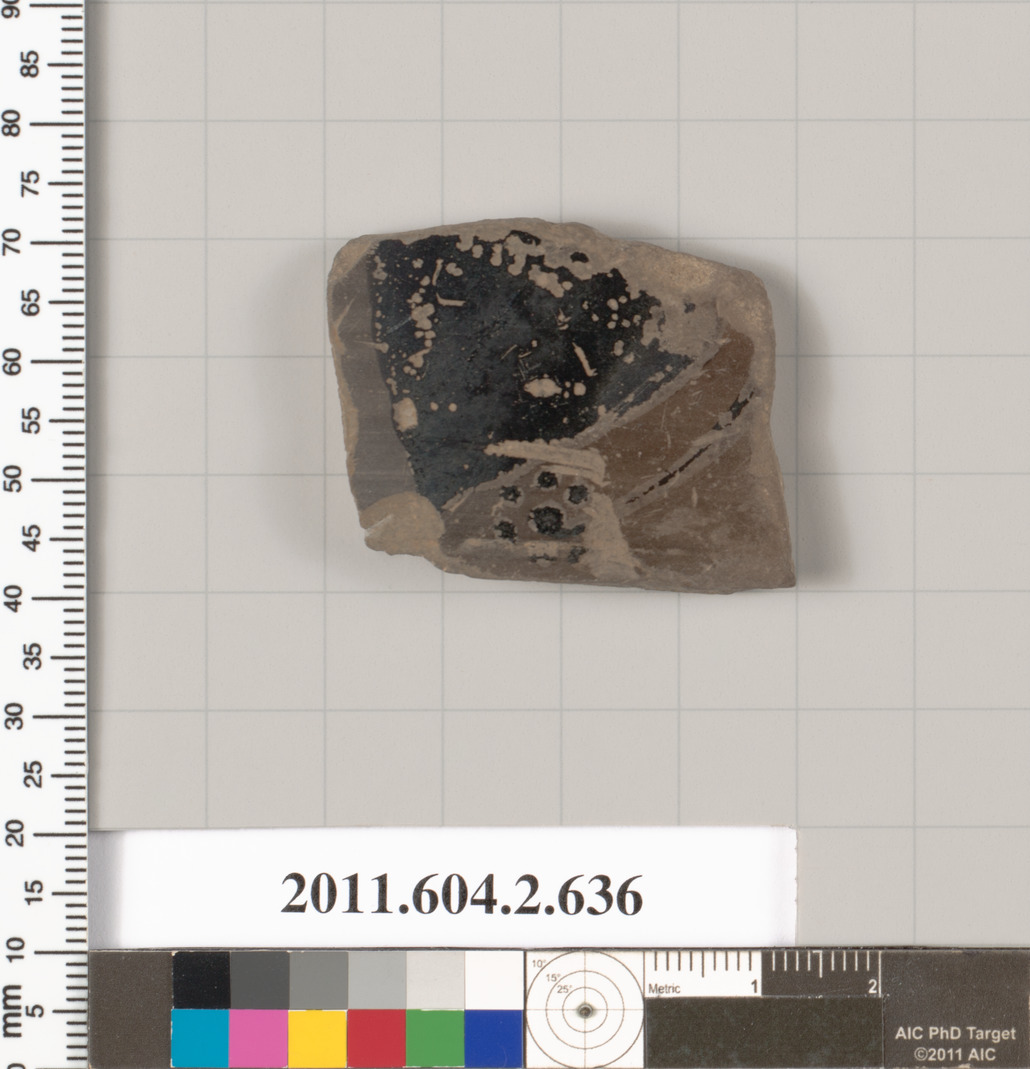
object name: column krater fragment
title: Terracotta fragment of a column-krater (bowl for mixing wine and water)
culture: greek, attic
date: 460-440 BCE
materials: terracotta